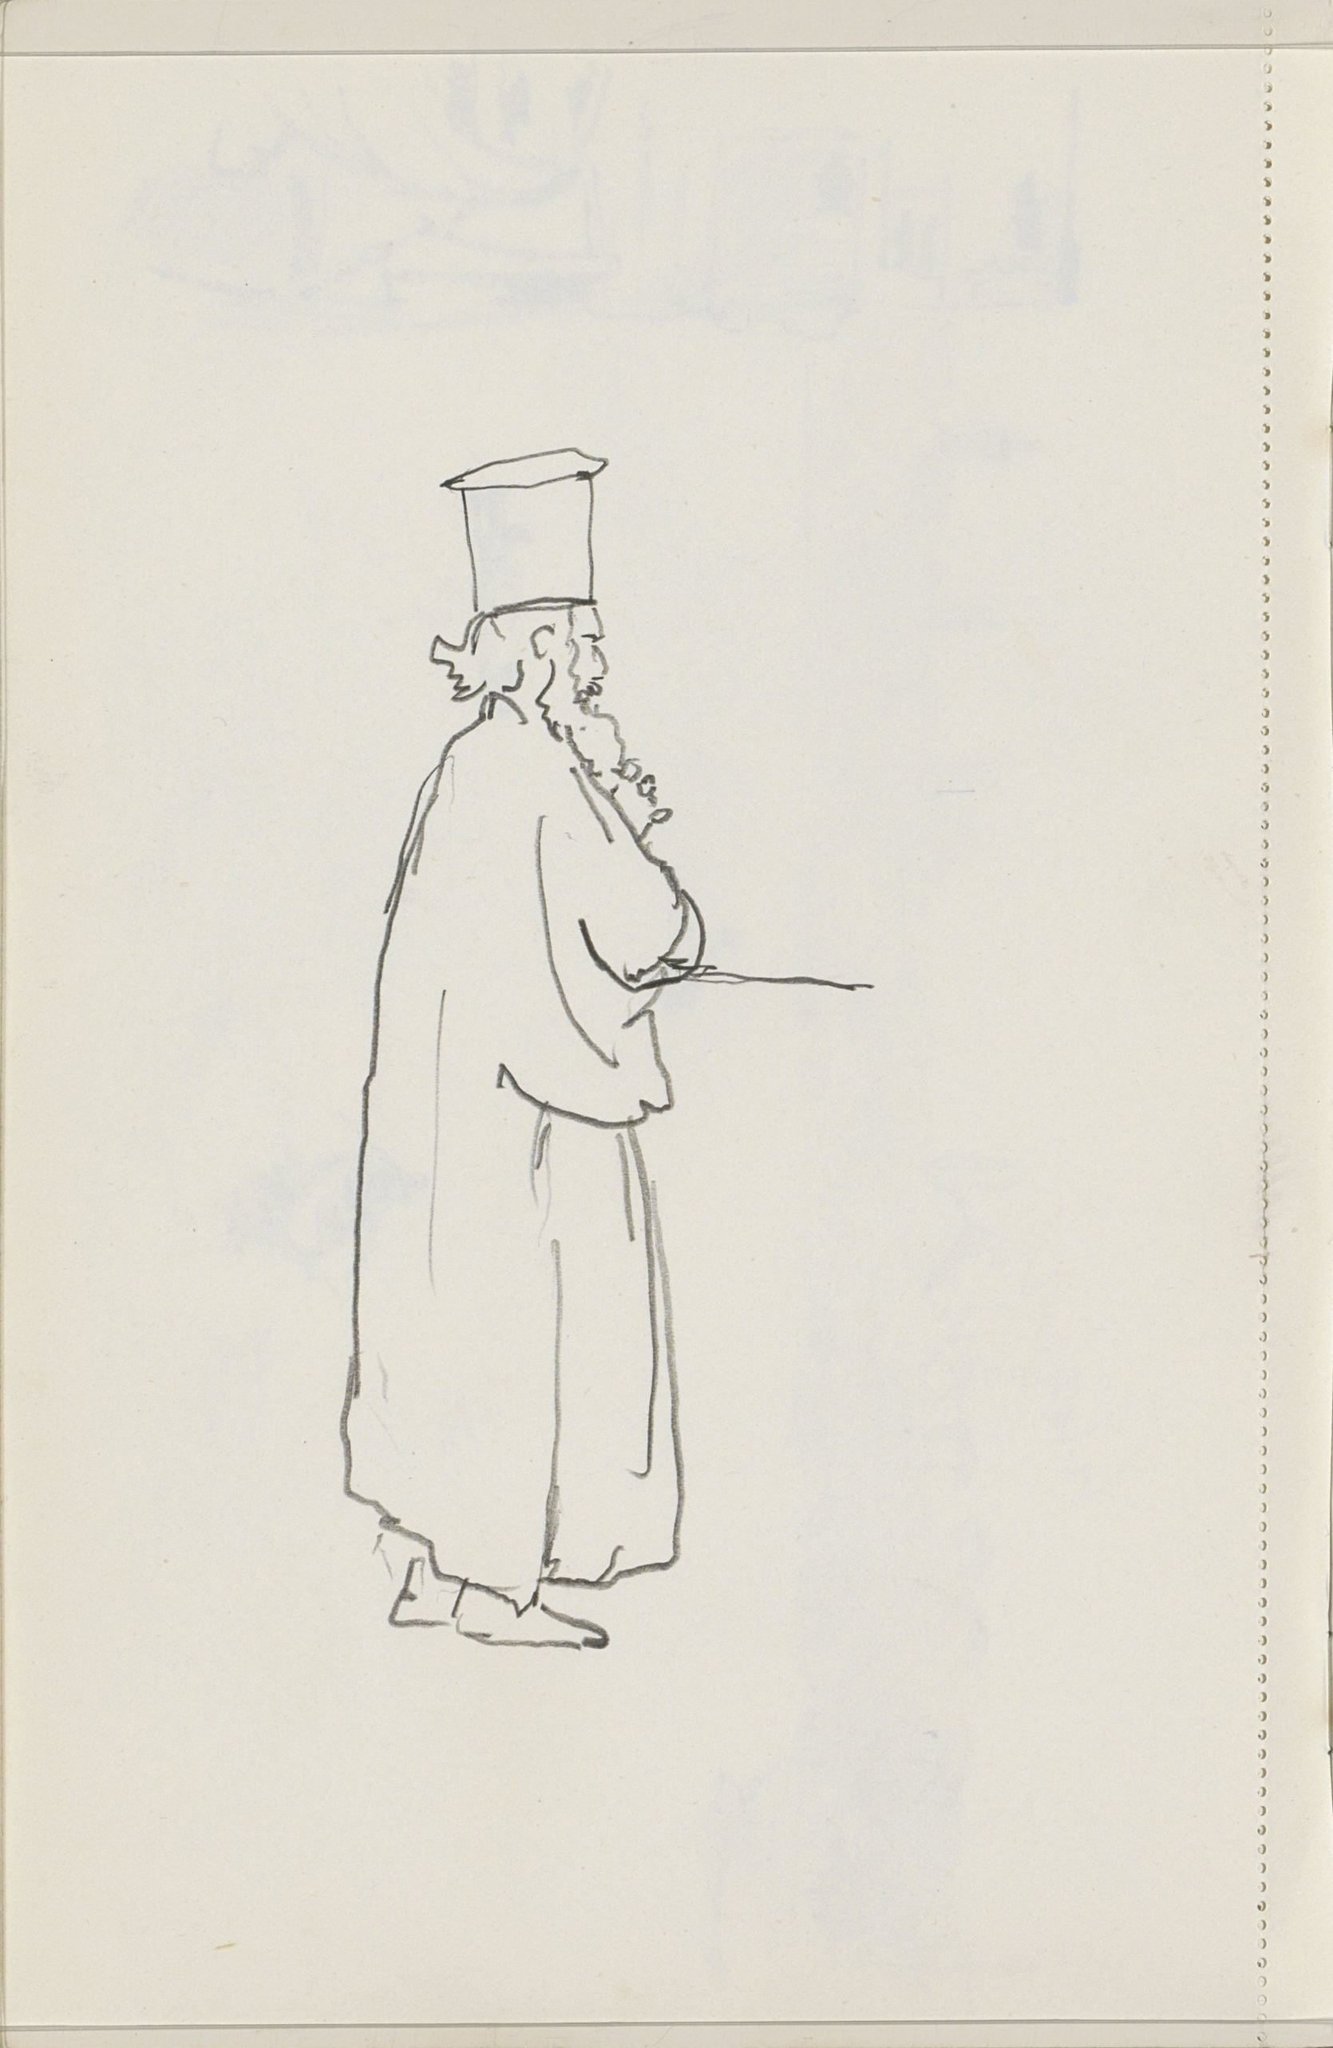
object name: sketchbook leaf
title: Staande man met een baard en hoge hoed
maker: cornelis vreedenburgh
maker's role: draughtsman, print maker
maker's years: 1880-1946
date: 1935-1936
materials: paper, pencil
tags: standing figure, head-gear: top hat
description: Blad 57 verso uit een schetsboek met 73 bladen.